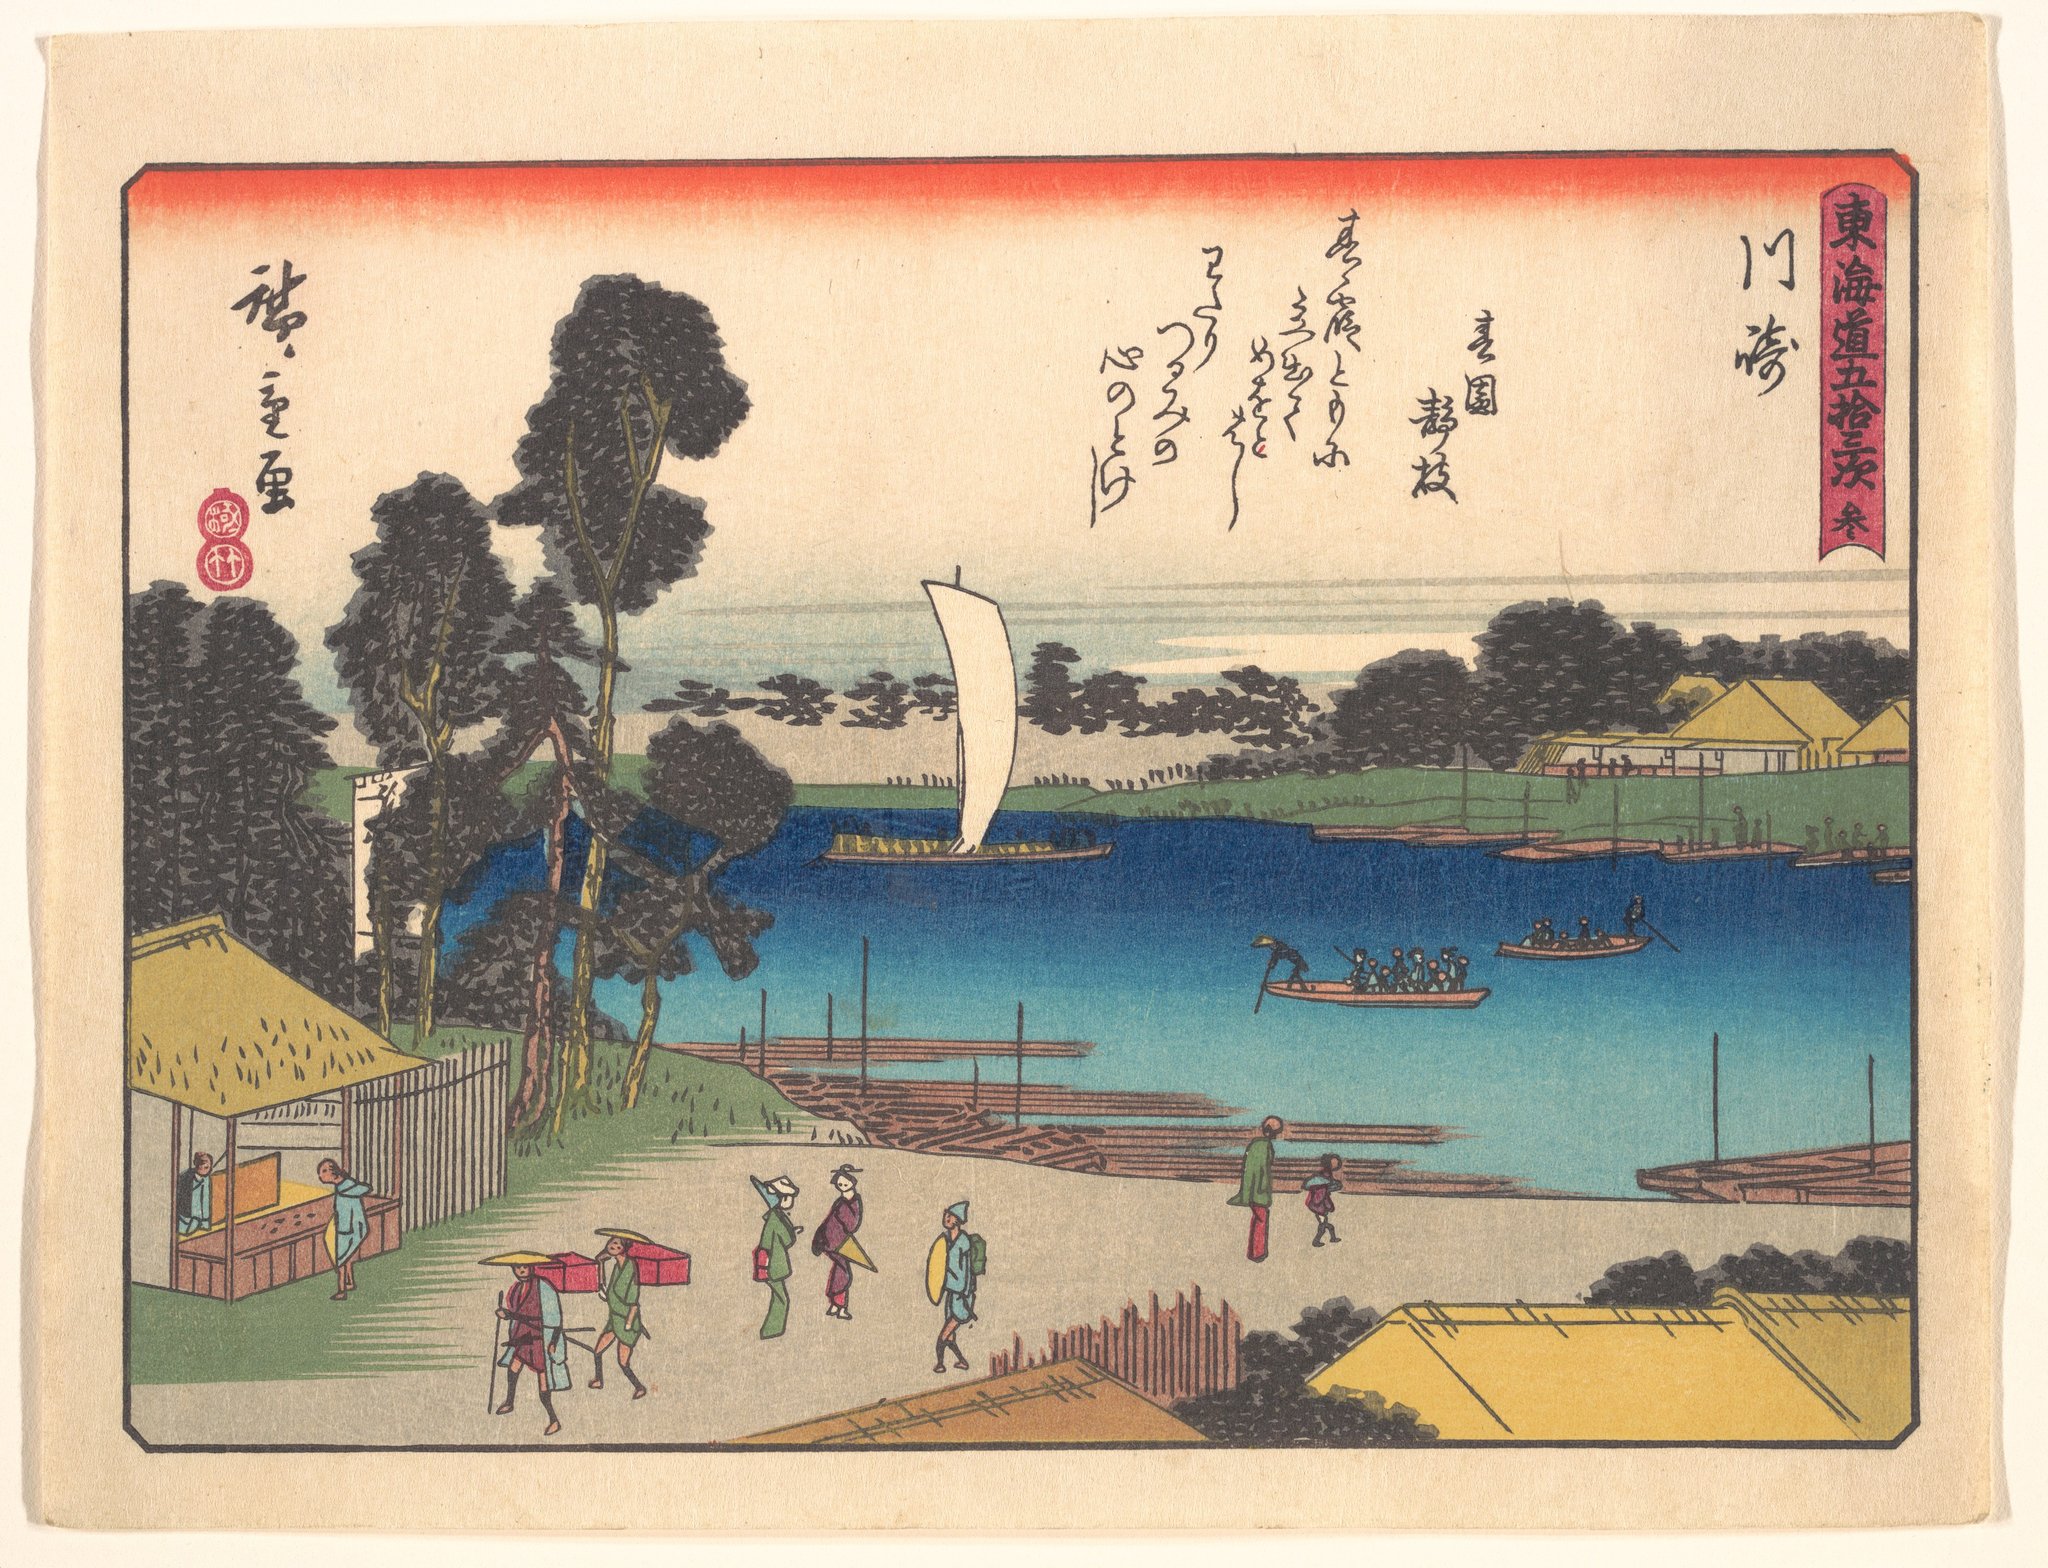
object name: print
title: 東海道五十三次 川崎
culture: japanese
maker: utagawa hiroshige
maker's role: artist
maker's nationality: japanese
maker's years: 1797-1858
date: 1901-1933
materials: ink, paper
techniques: woodblock print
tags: human figures,rivers,landscapes,boats